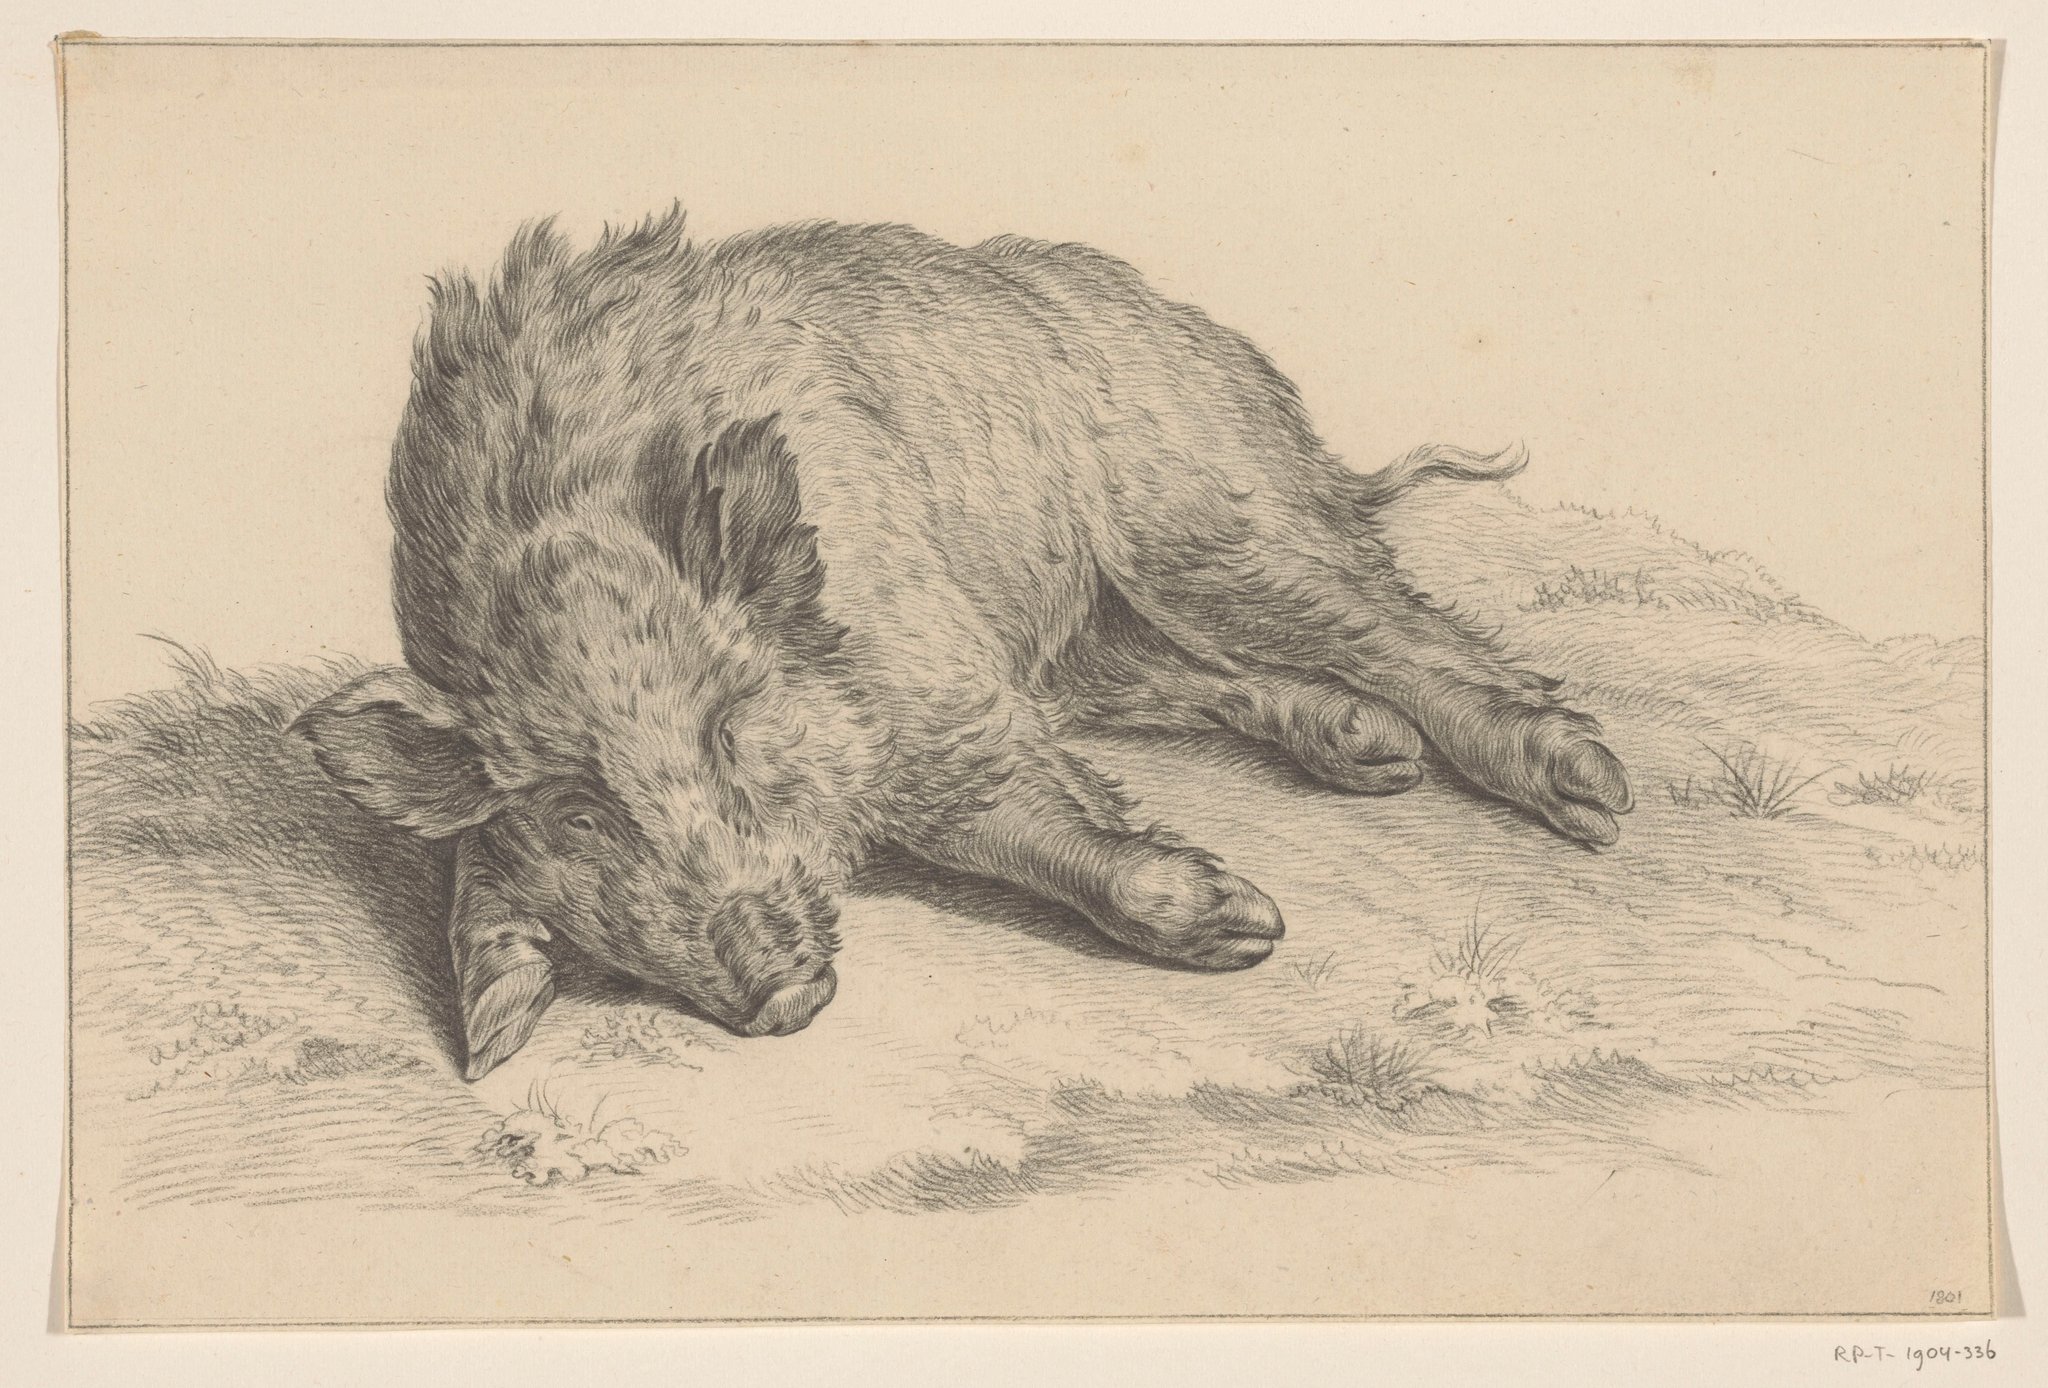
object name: drawing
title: Liggend wild zwijn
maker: jean bernard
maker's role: draughtsman, print maker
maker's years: 1765-1833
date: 1801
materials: chalk, paper, pencil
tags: hoofed animals: boar